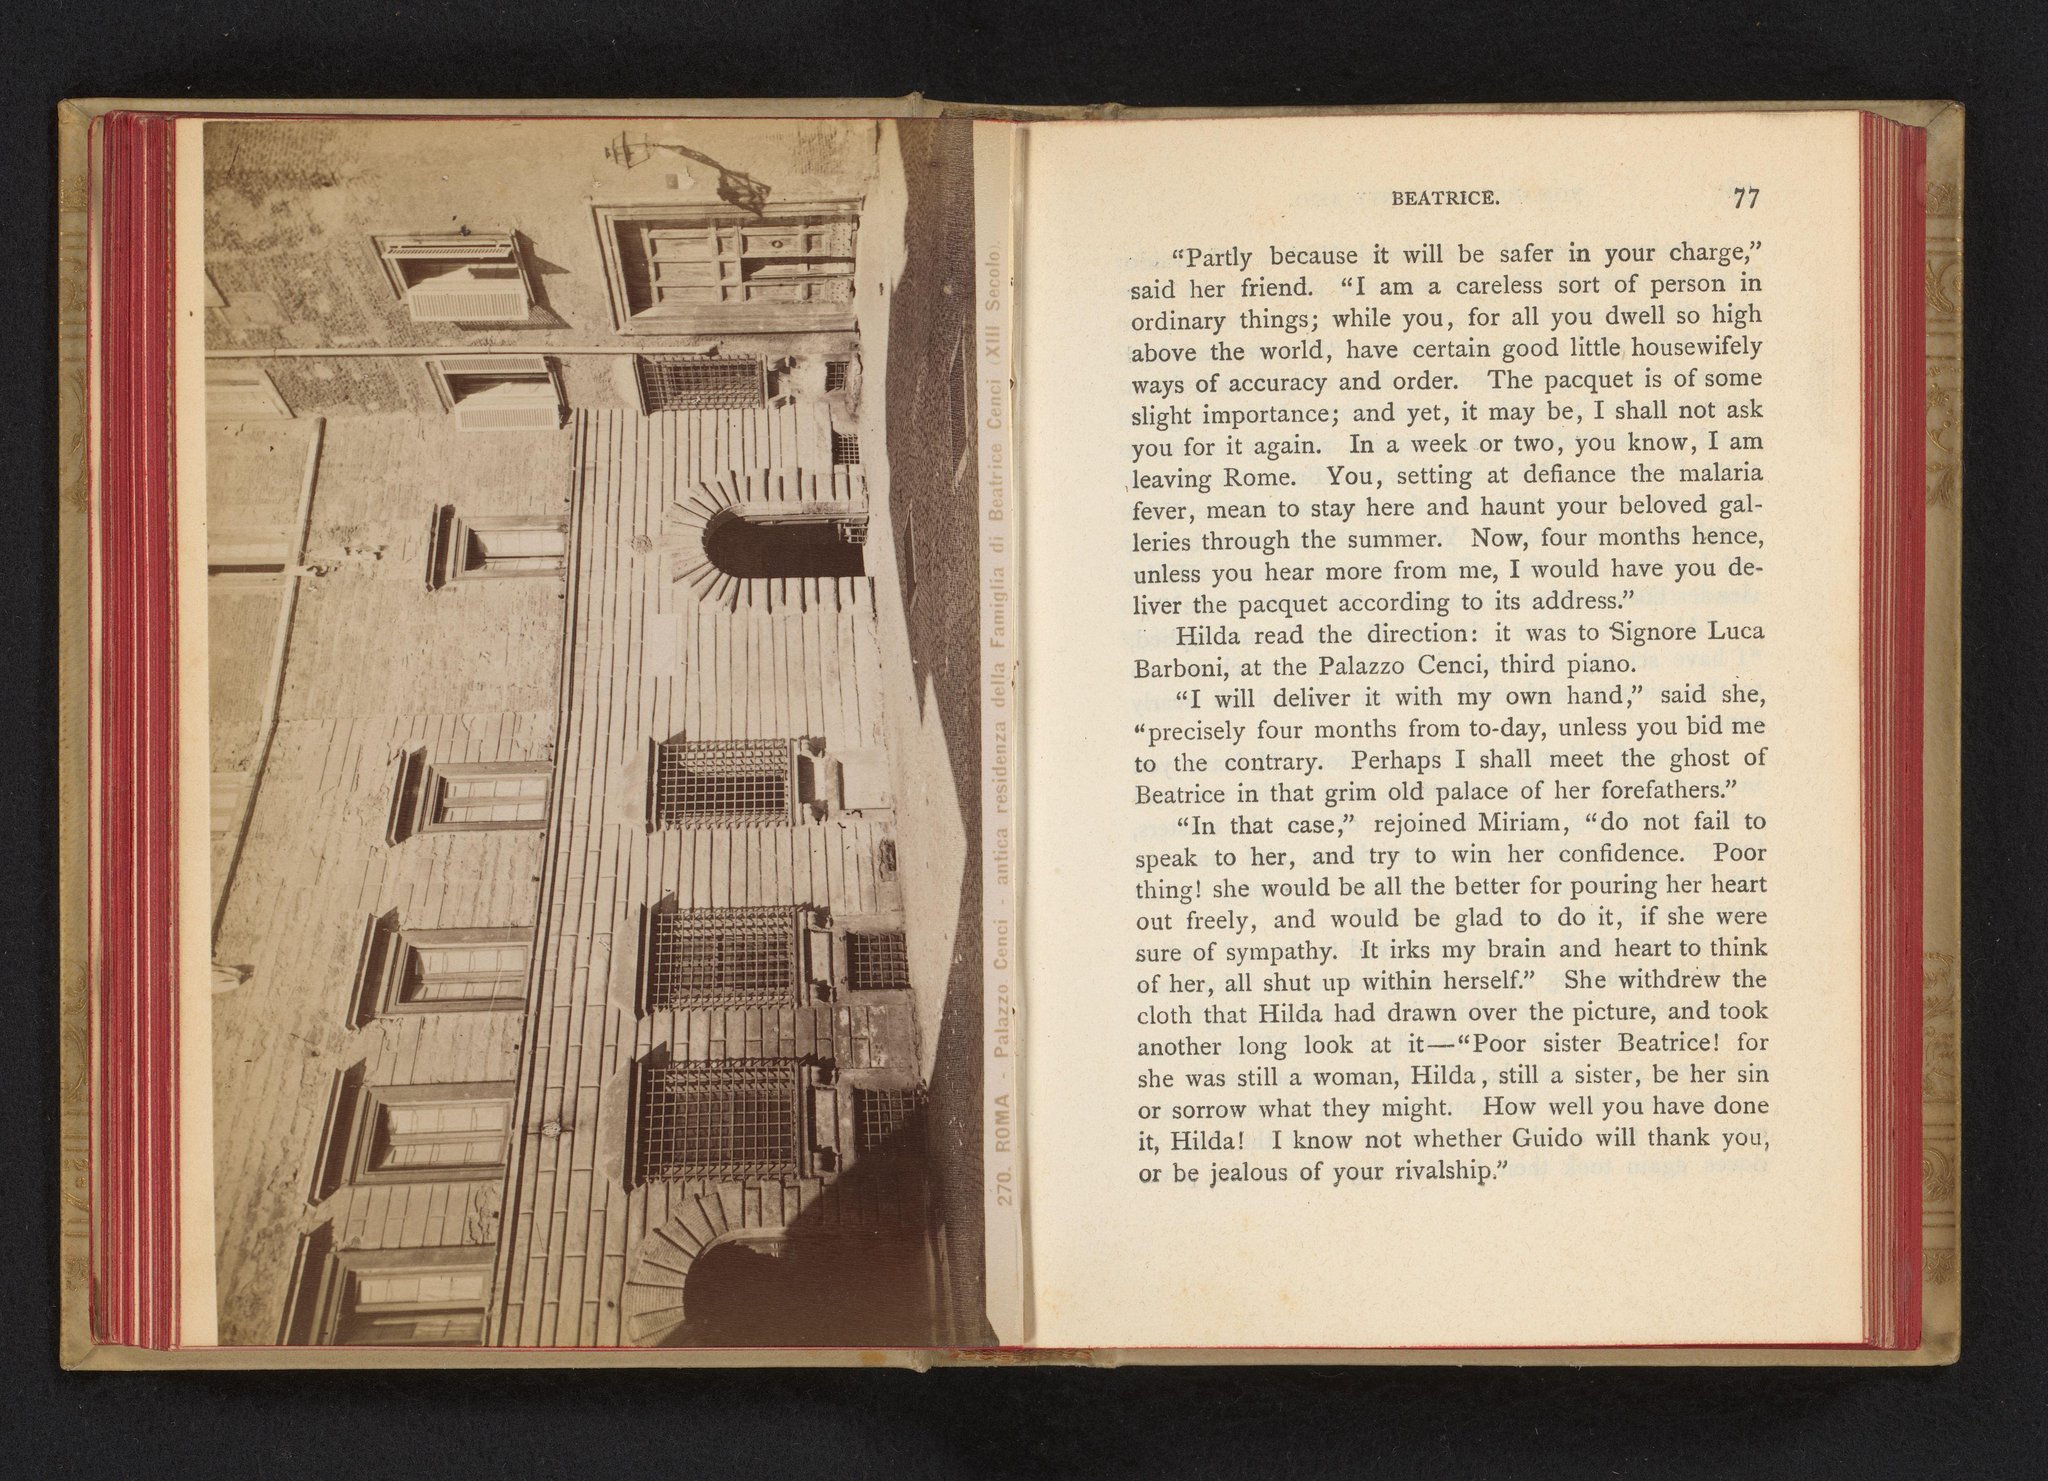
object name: page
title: Palazzo Cenci in Rome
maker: Anonymous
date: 1855-1860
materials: paper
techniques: albumen print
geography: rome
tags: hôtel, i.e. small palace in city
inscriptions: number: ‘270.’